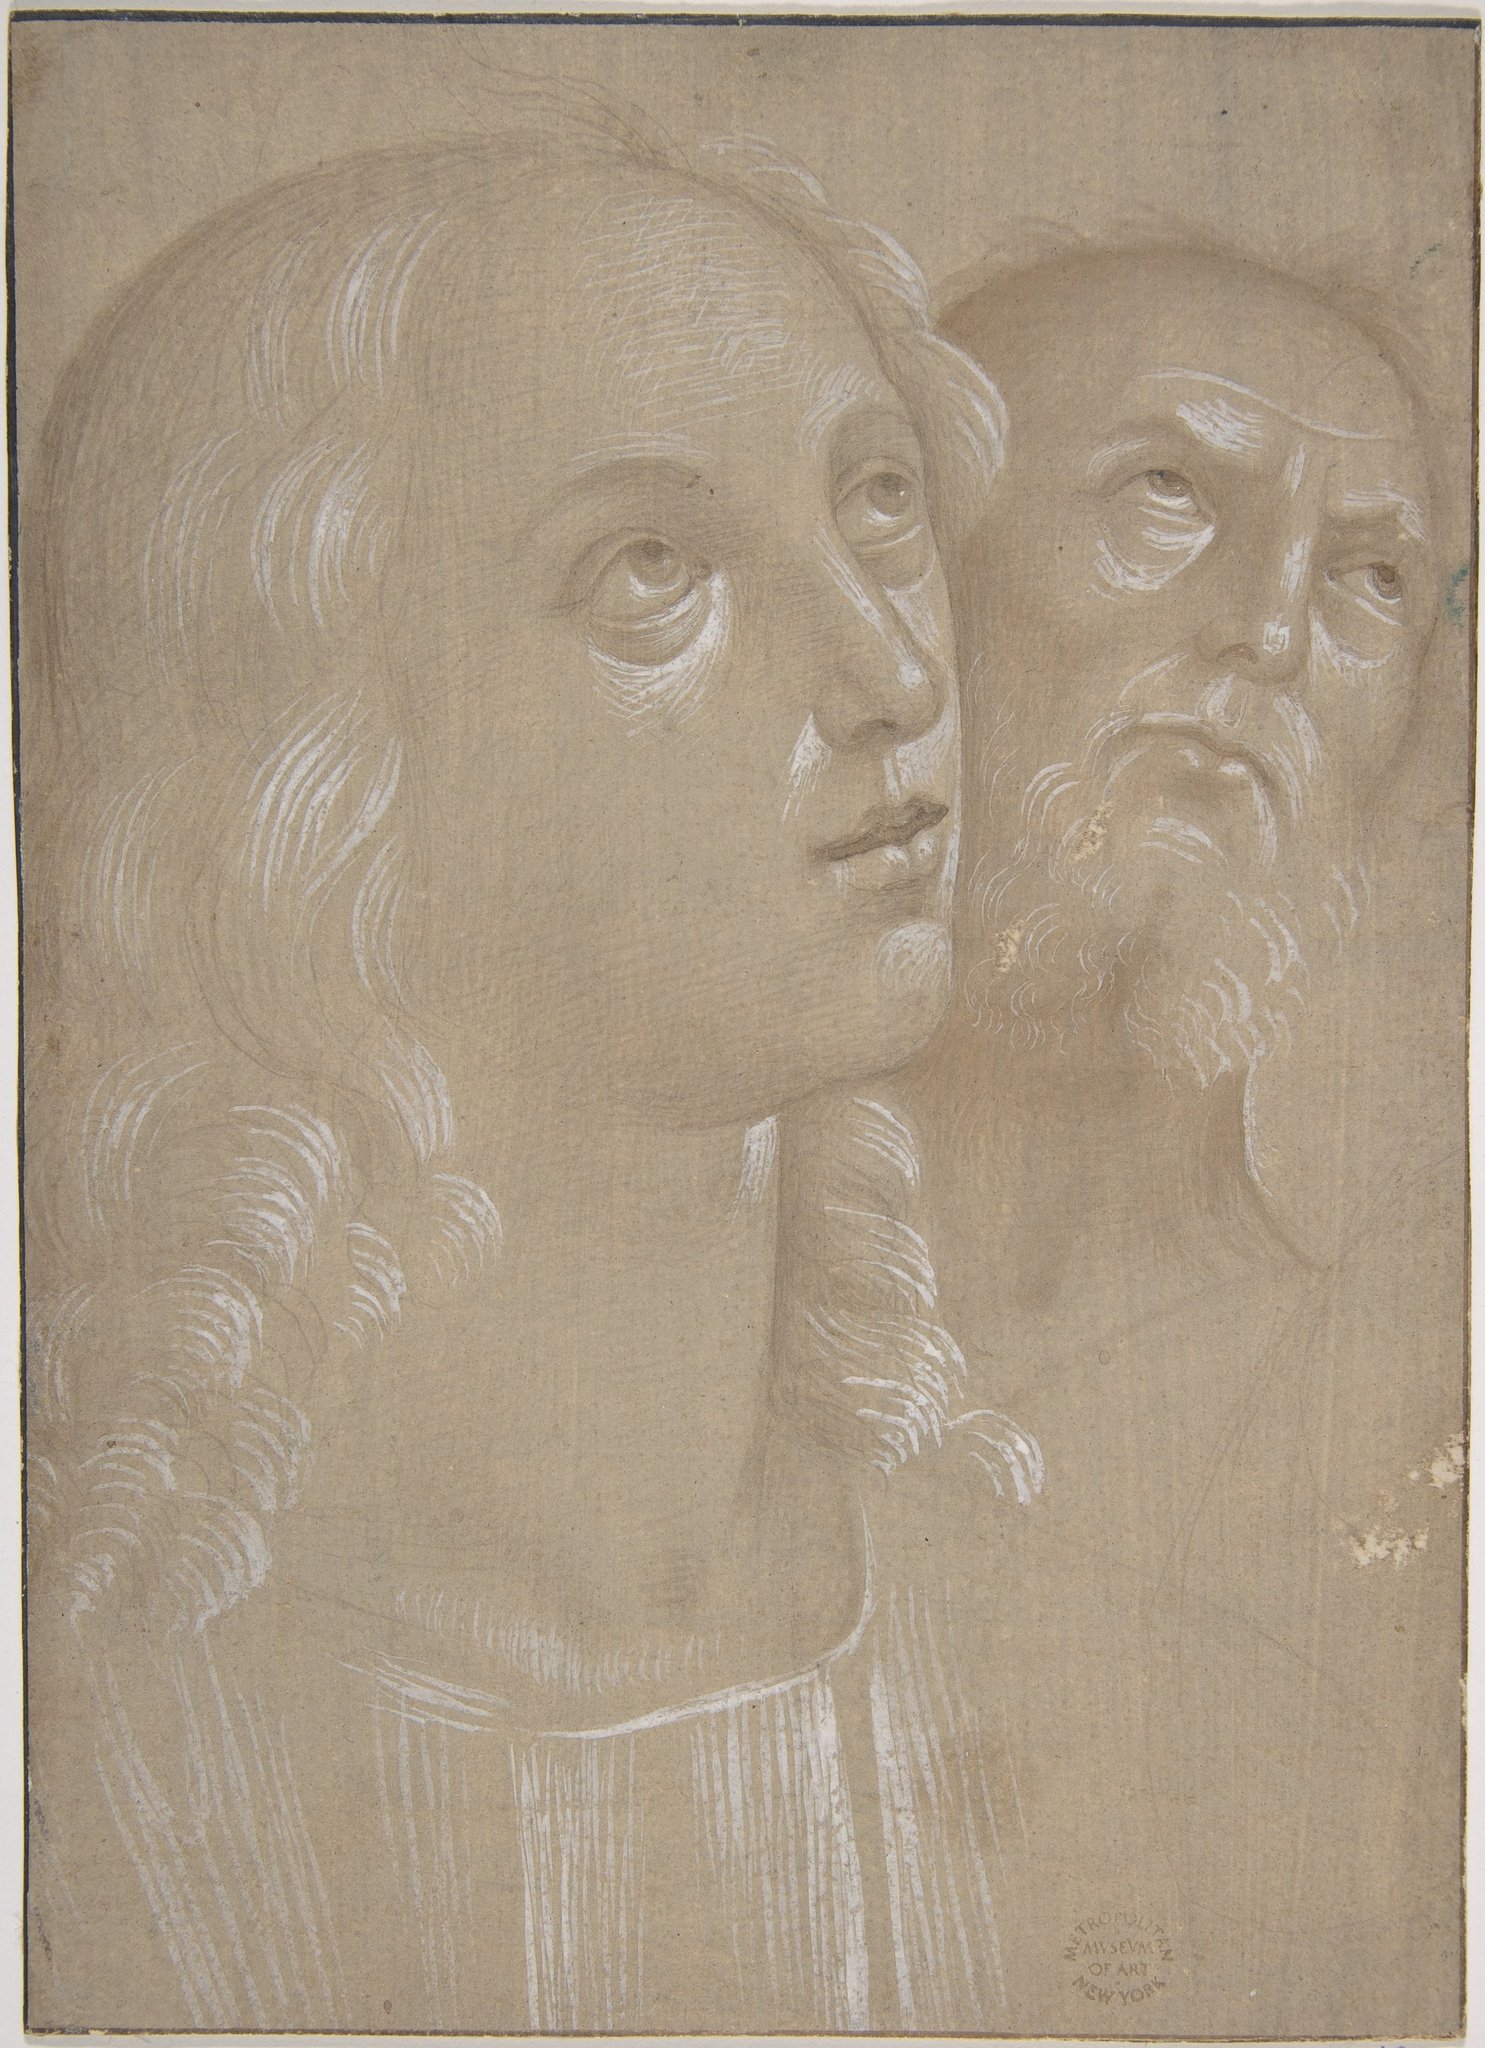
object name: drawing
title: Heads of Two Saints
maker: perugino (pietro di cristoforo vannucci)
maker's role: artist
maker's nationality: italian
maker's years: 1469-1523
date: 1495-1510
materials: gouache, paper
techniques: brush, highlighting, wash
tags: heads,men,women,saints